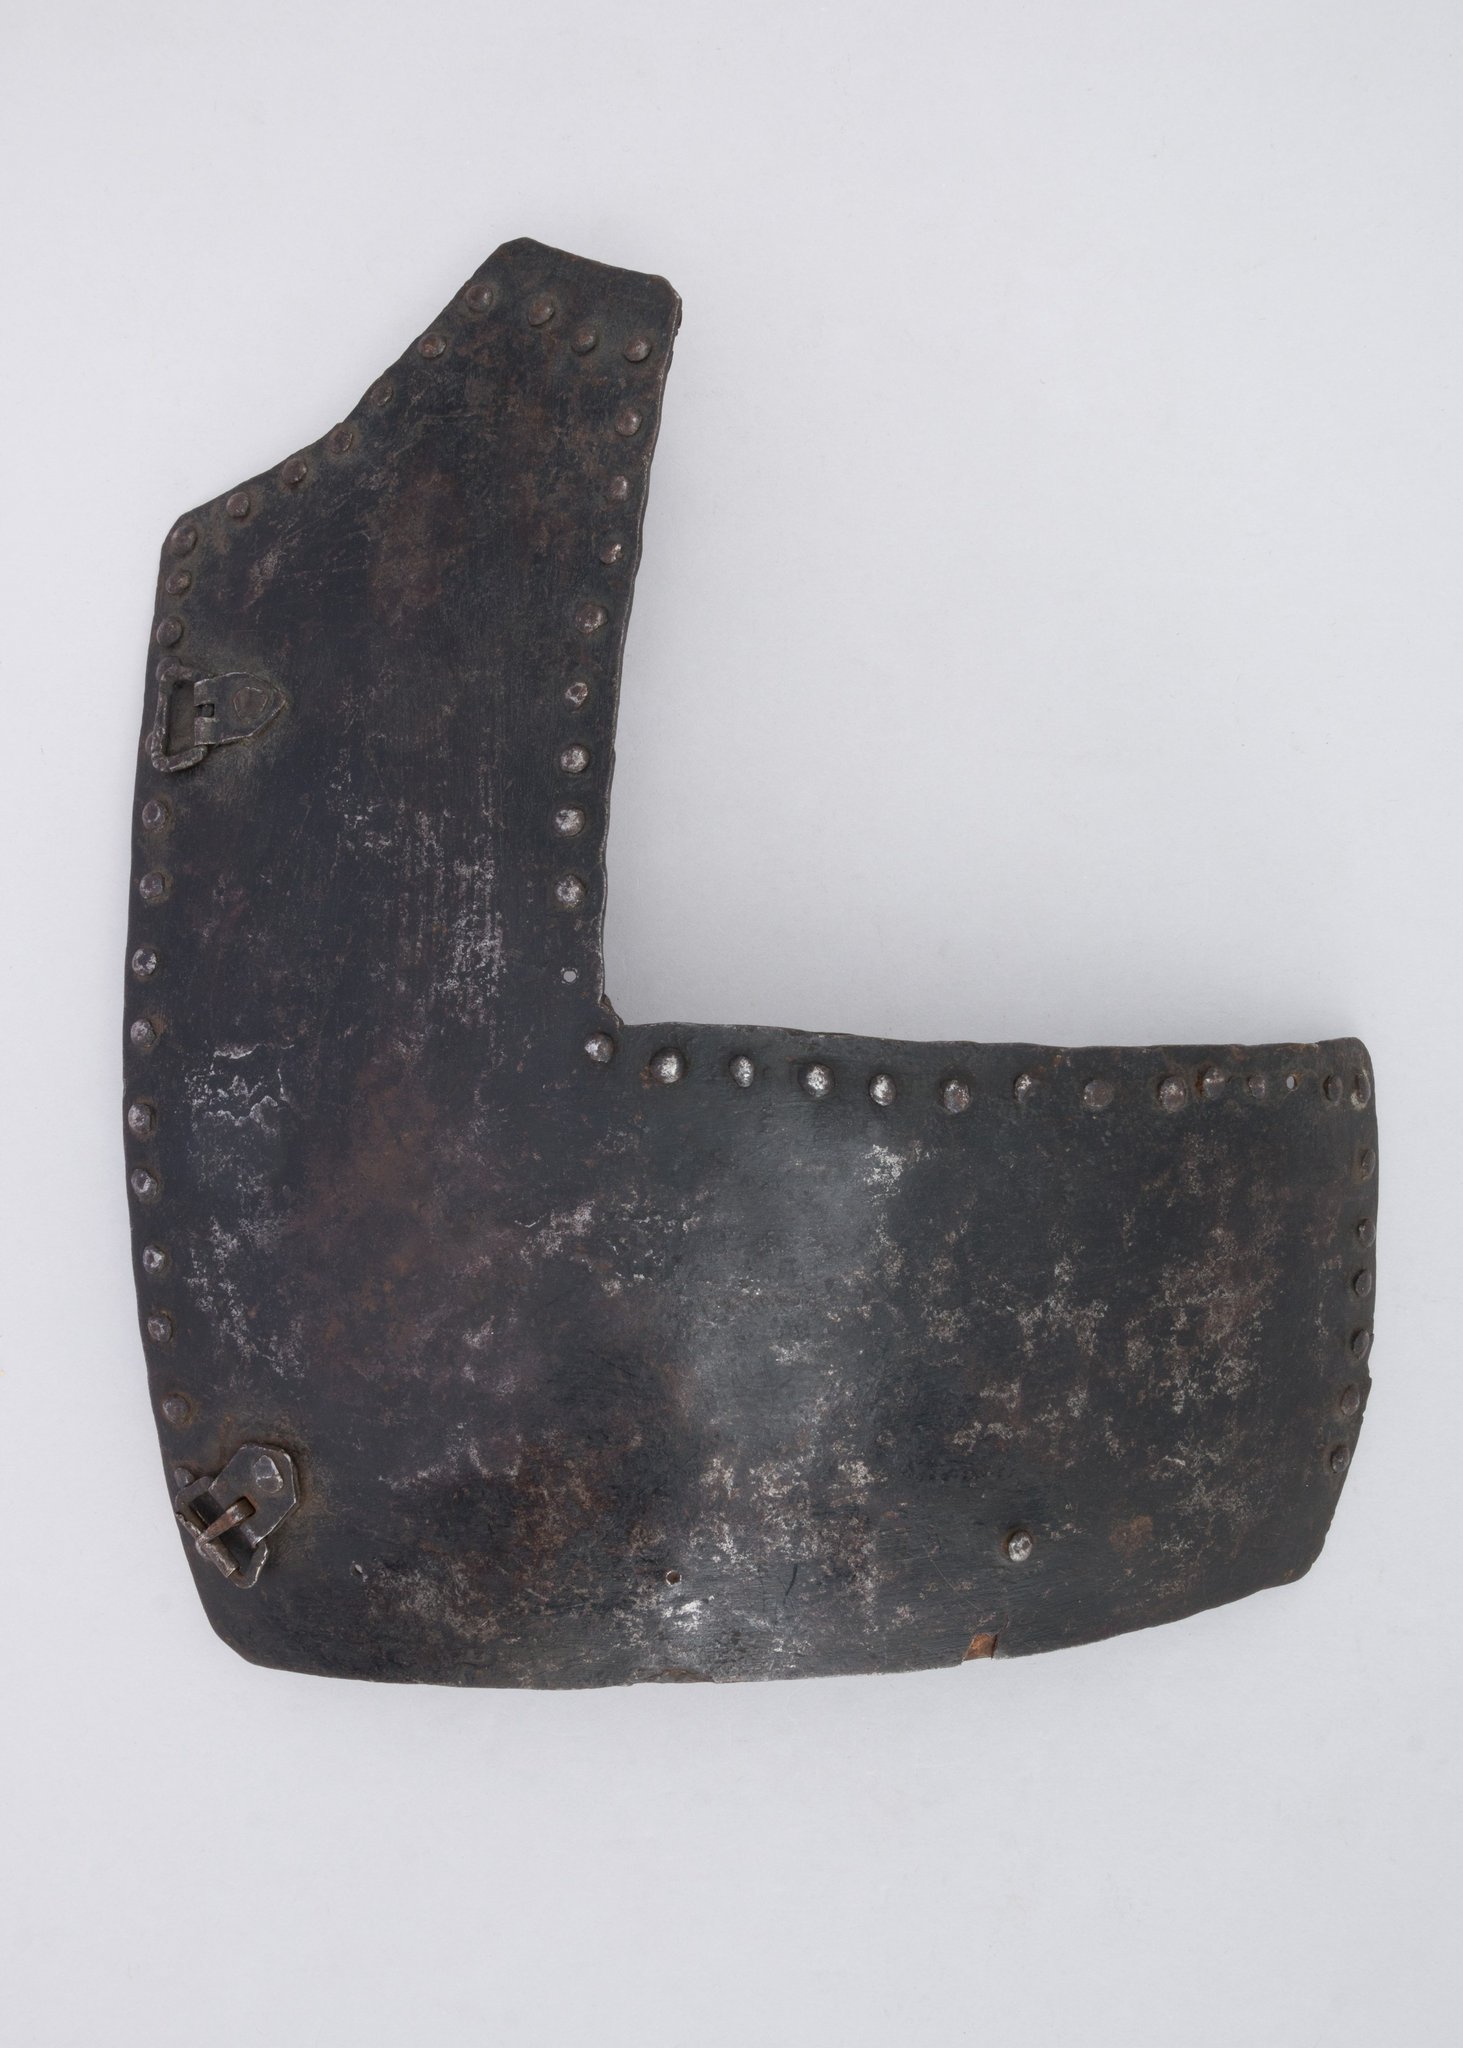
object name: brigandine plate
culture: italian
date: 1400-1450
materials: metal alloy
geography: italy